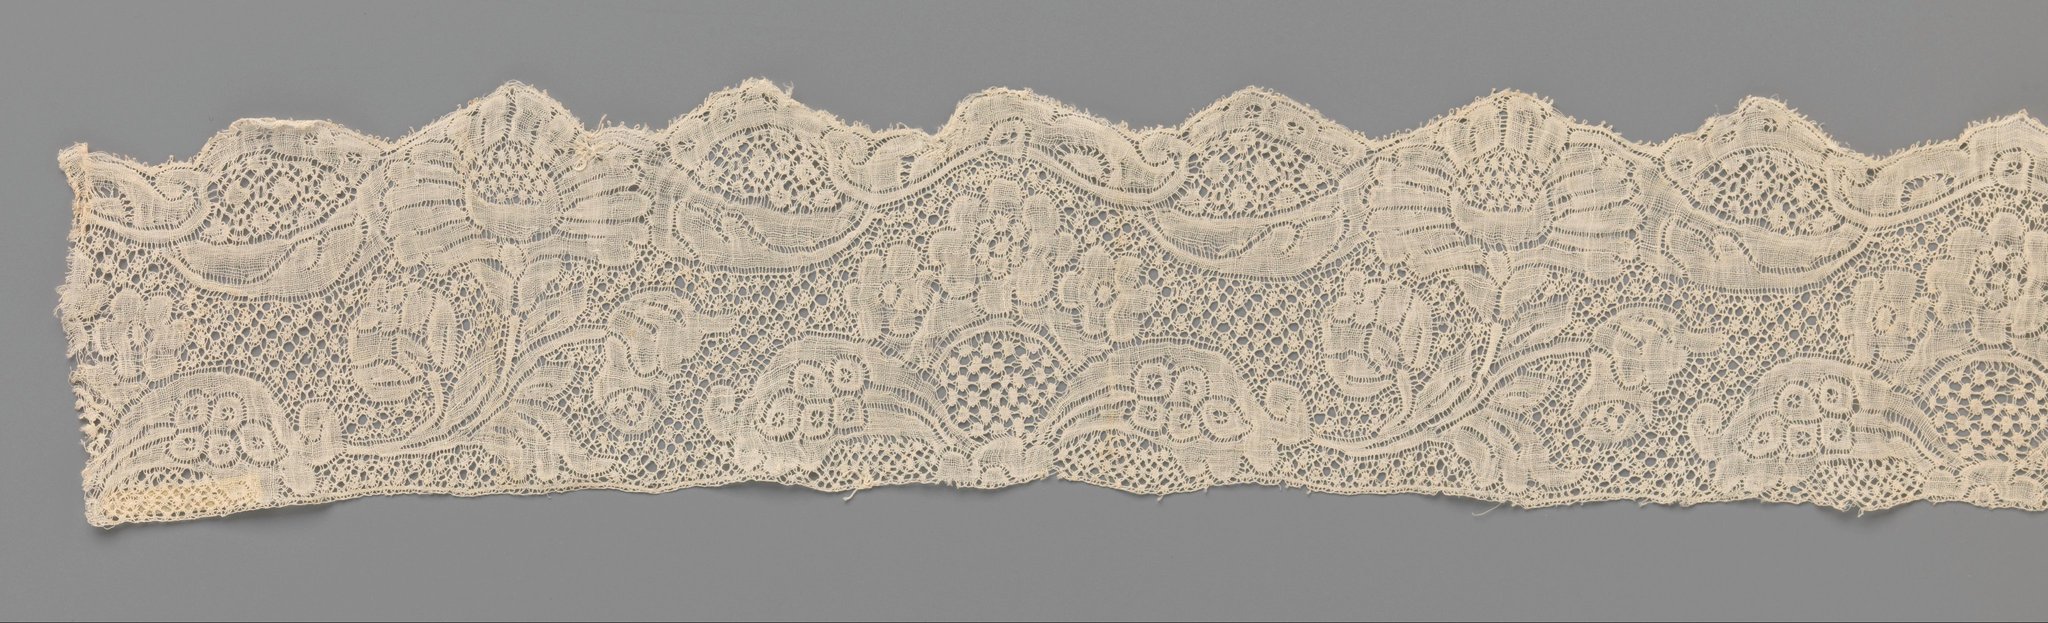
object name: strip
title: Strook kloskant met cartouche waaruit een margriet ontspringt die een schulp vormt langs de onderrand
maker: Anonymous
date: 1725-1749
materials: linen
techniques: lace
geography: southern netherlands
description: Strook naturelkleurige kloskant, Binche-kant. Het zich herhalende patroon bestaat uit een cartouche langs de bovenrand, met brede voluutbladeren die zich naar links en rechts uitstrekken. Uit één van de voluutbladeren ontspringt een bloemstengel, die naar de onderzijde afbuigt en met een grote margriet één van de schulpen vormt. Tussen de opeenvolgende margrieten worden de andere schulpen gevormd door een langgerekt voluut, dat links en rechts geflankeerd wordt door een min of meer spitsovaalvormige cartouche. De motieven zijn met elkaar verbonden door een siergrond, een sneeuwvlokkengrond. Het volwerk is voornamelijk gemaakt in linnenslag met opengewerkte randjes en deels in netslag. In onder andere de cartouches en in bloemharten zijn siergronden toegepast Boven- en onderzijde zijn recht afgewerkt, waarbij de onderzijde is voorzien van picots. De strook bestaat uit twee gelijke delen, die in het midden met een naad aan elkaar zijn gezet.